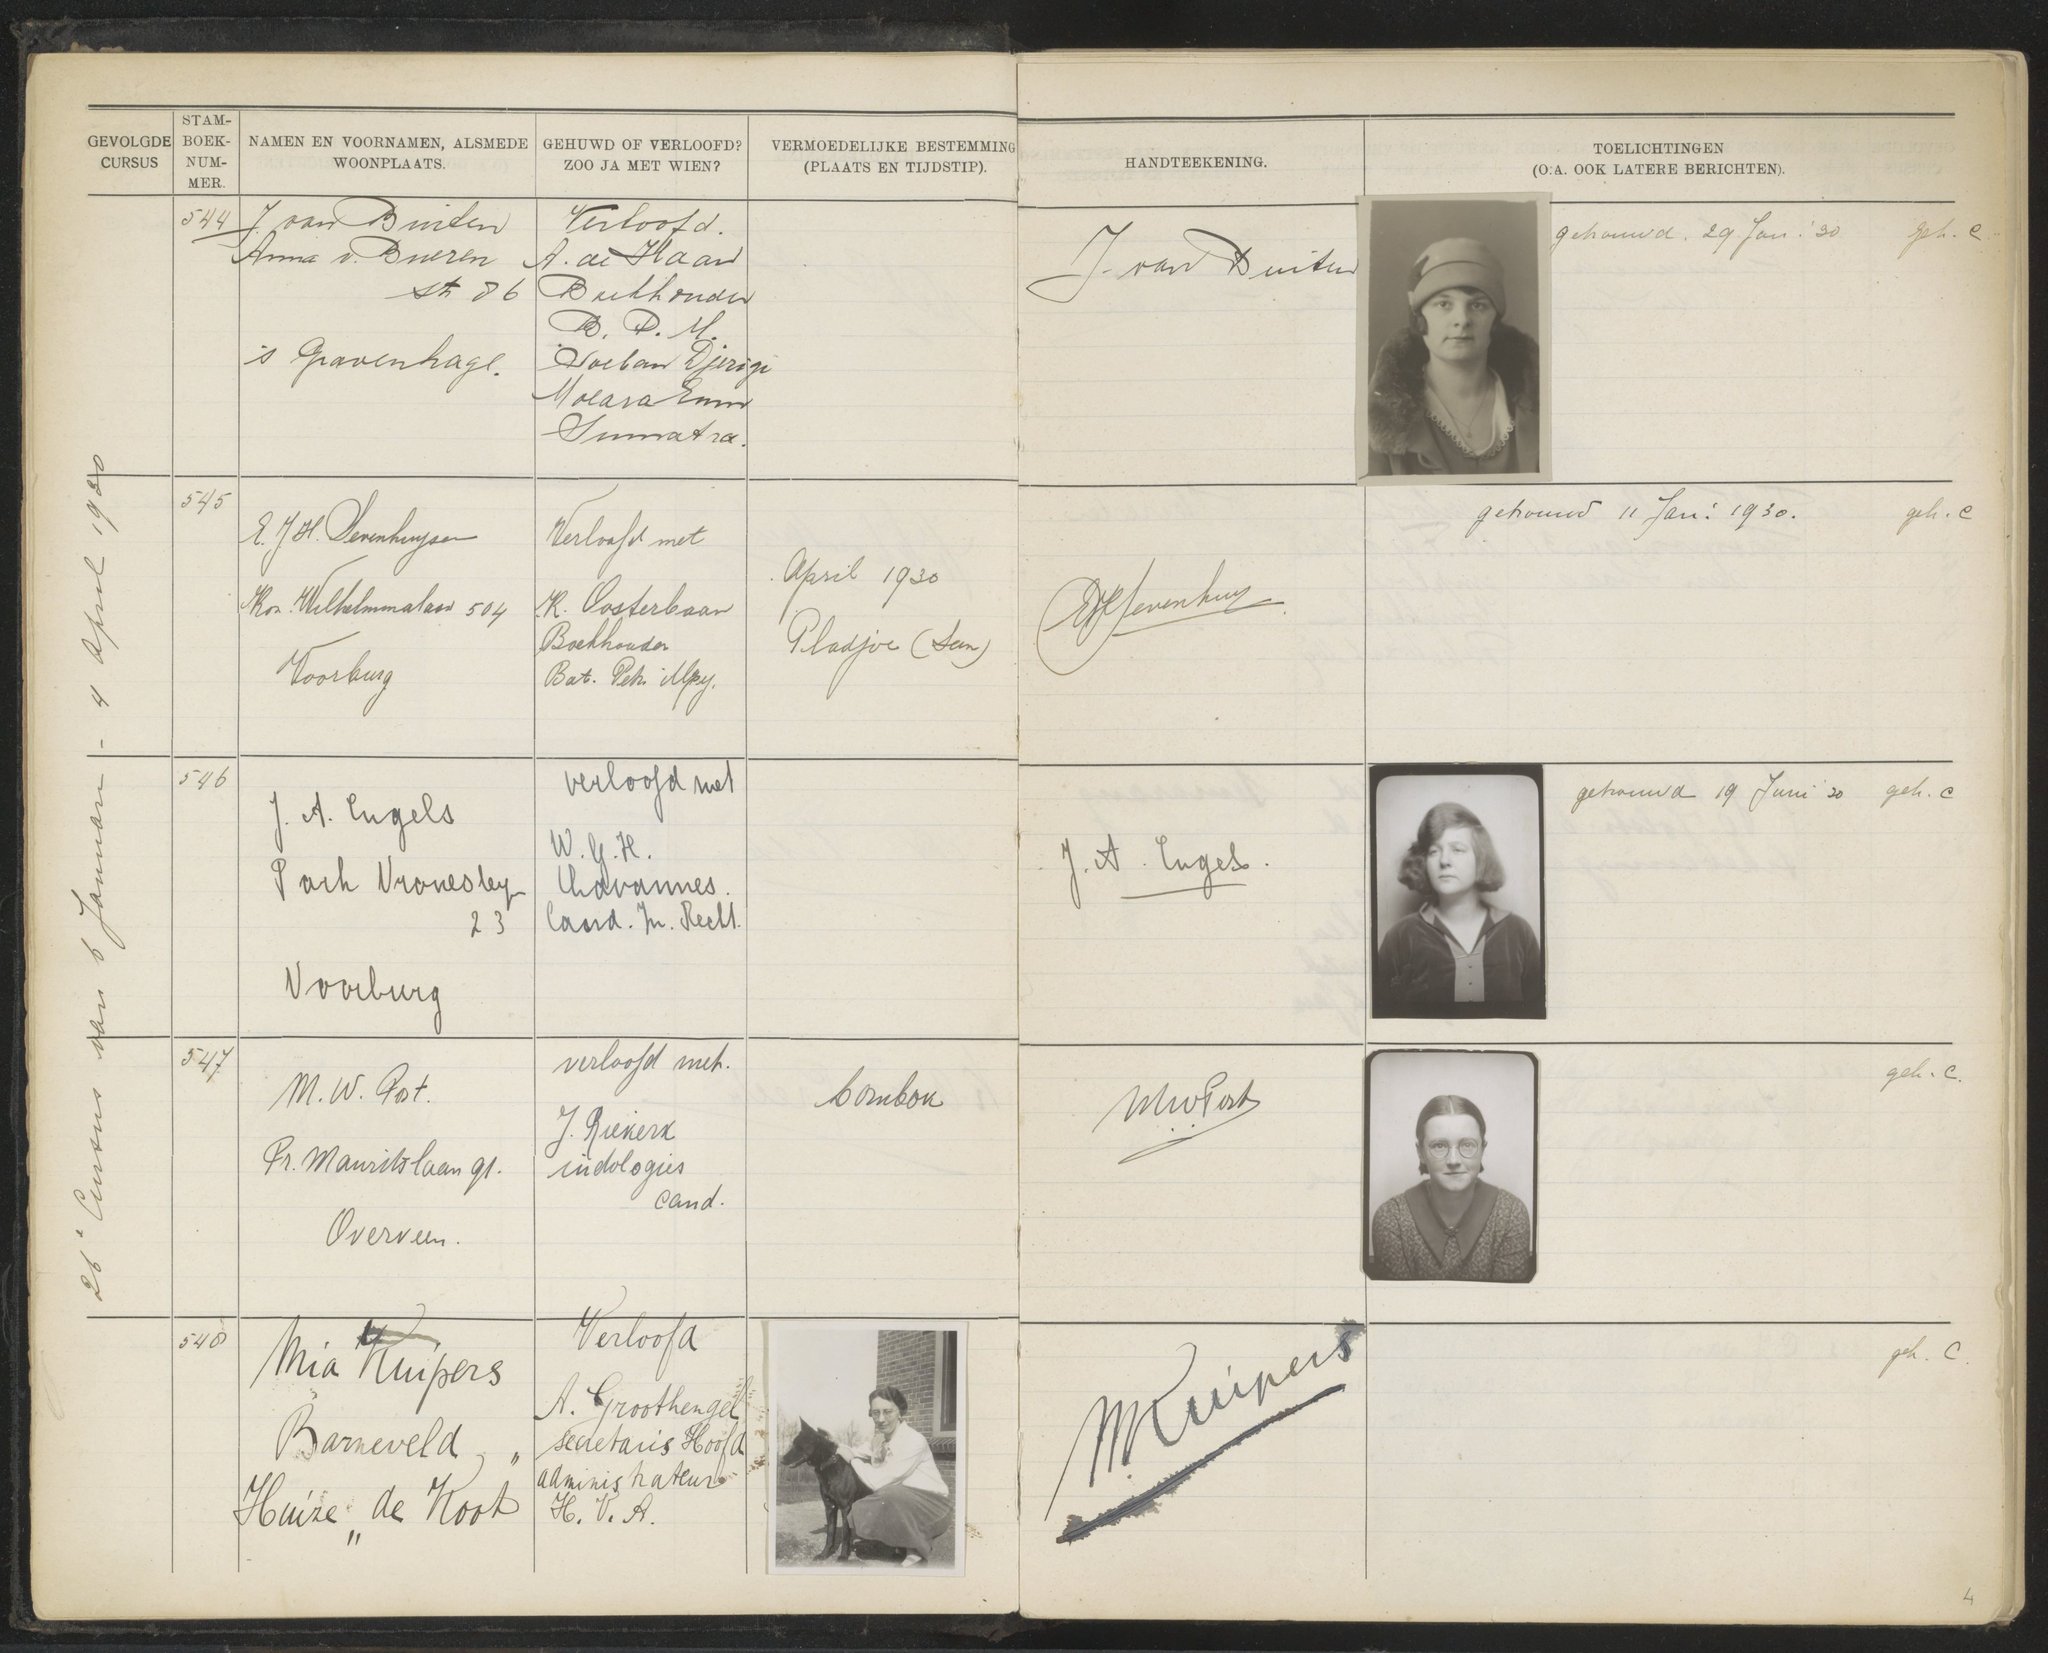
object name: album leaf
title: Blad 4 uit Stamboek van de leerlingen der Koloniale School voor Meisjes en Vrouwen te 's-Gravenhage deel II (1930-1949)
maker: Anonymous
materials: paper, photographic support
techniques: photography, printing, writing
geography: the hague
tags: further education (+ pupil), further education, the hague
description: Twee pagina's met gegevens van de deelnemers aan de 26e driemaandelijkse cursus van 6 januari 1930 tot en met 4 april 1930, stamboeknummers 544 tot en met 548. Onderdeel van Stamboek van de leerlingen der Koloniale School voor Meisjes en Vrouwen te 's-Gravenhage deel II (1930-1949).